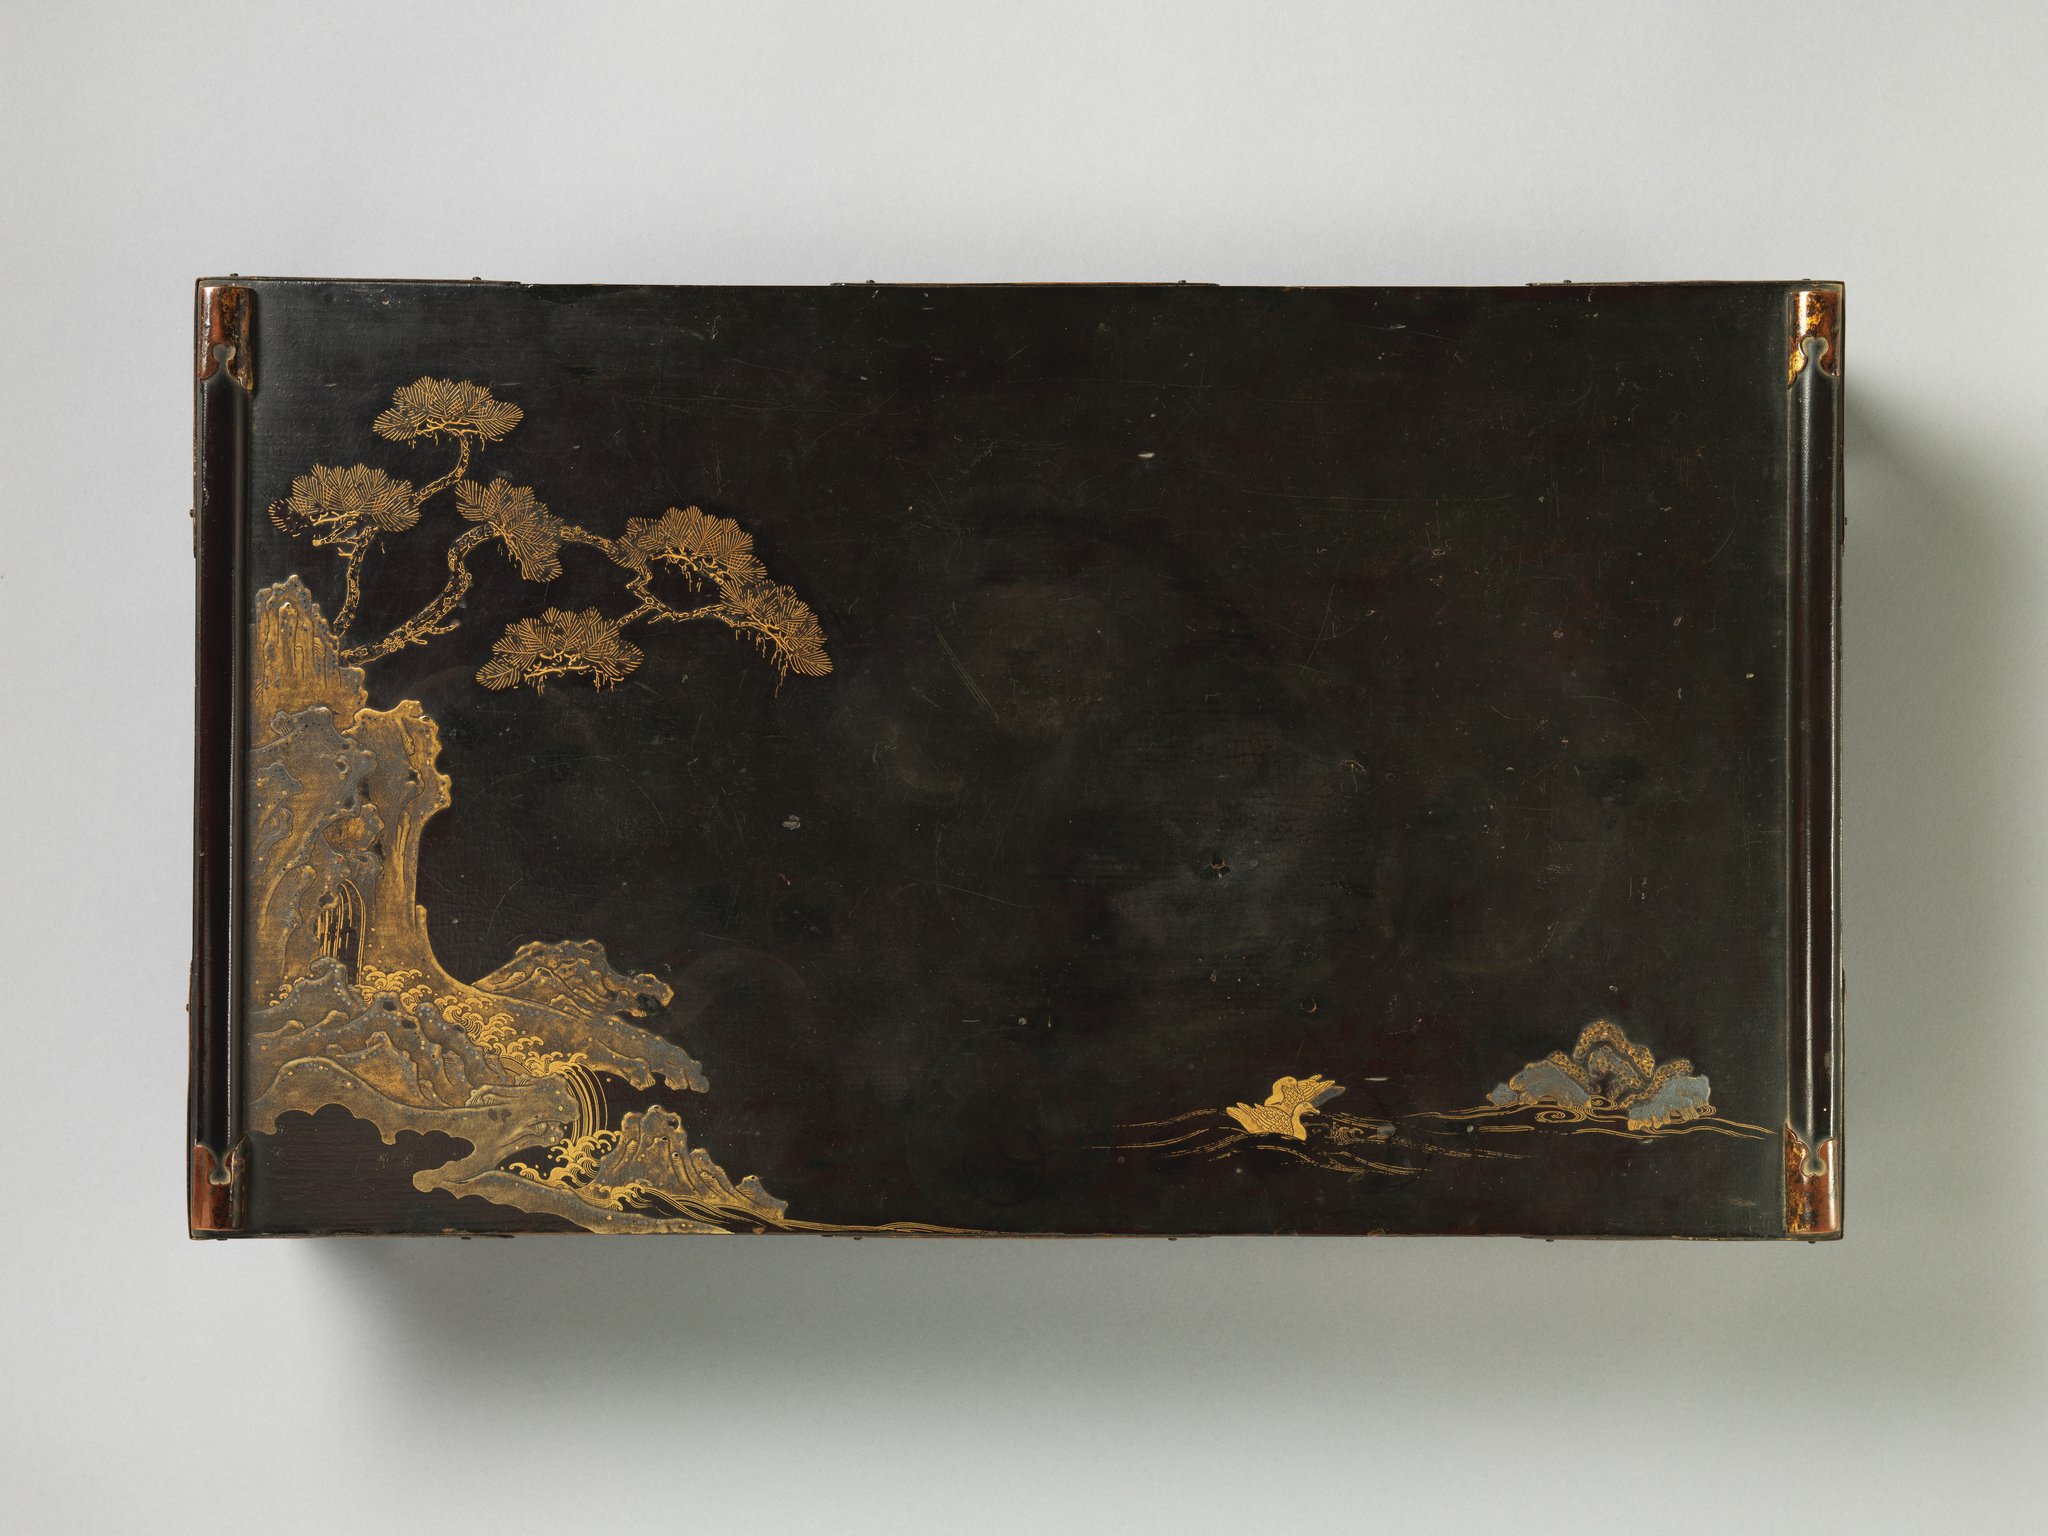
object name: writing desk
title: Writing Desk (Bundai) with Landscape and Geese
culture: japanese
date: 1601-1700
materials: foil, gold, silver, wood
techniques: hiramakie, lacquer, maki-e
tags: waterfalls,trees,tables